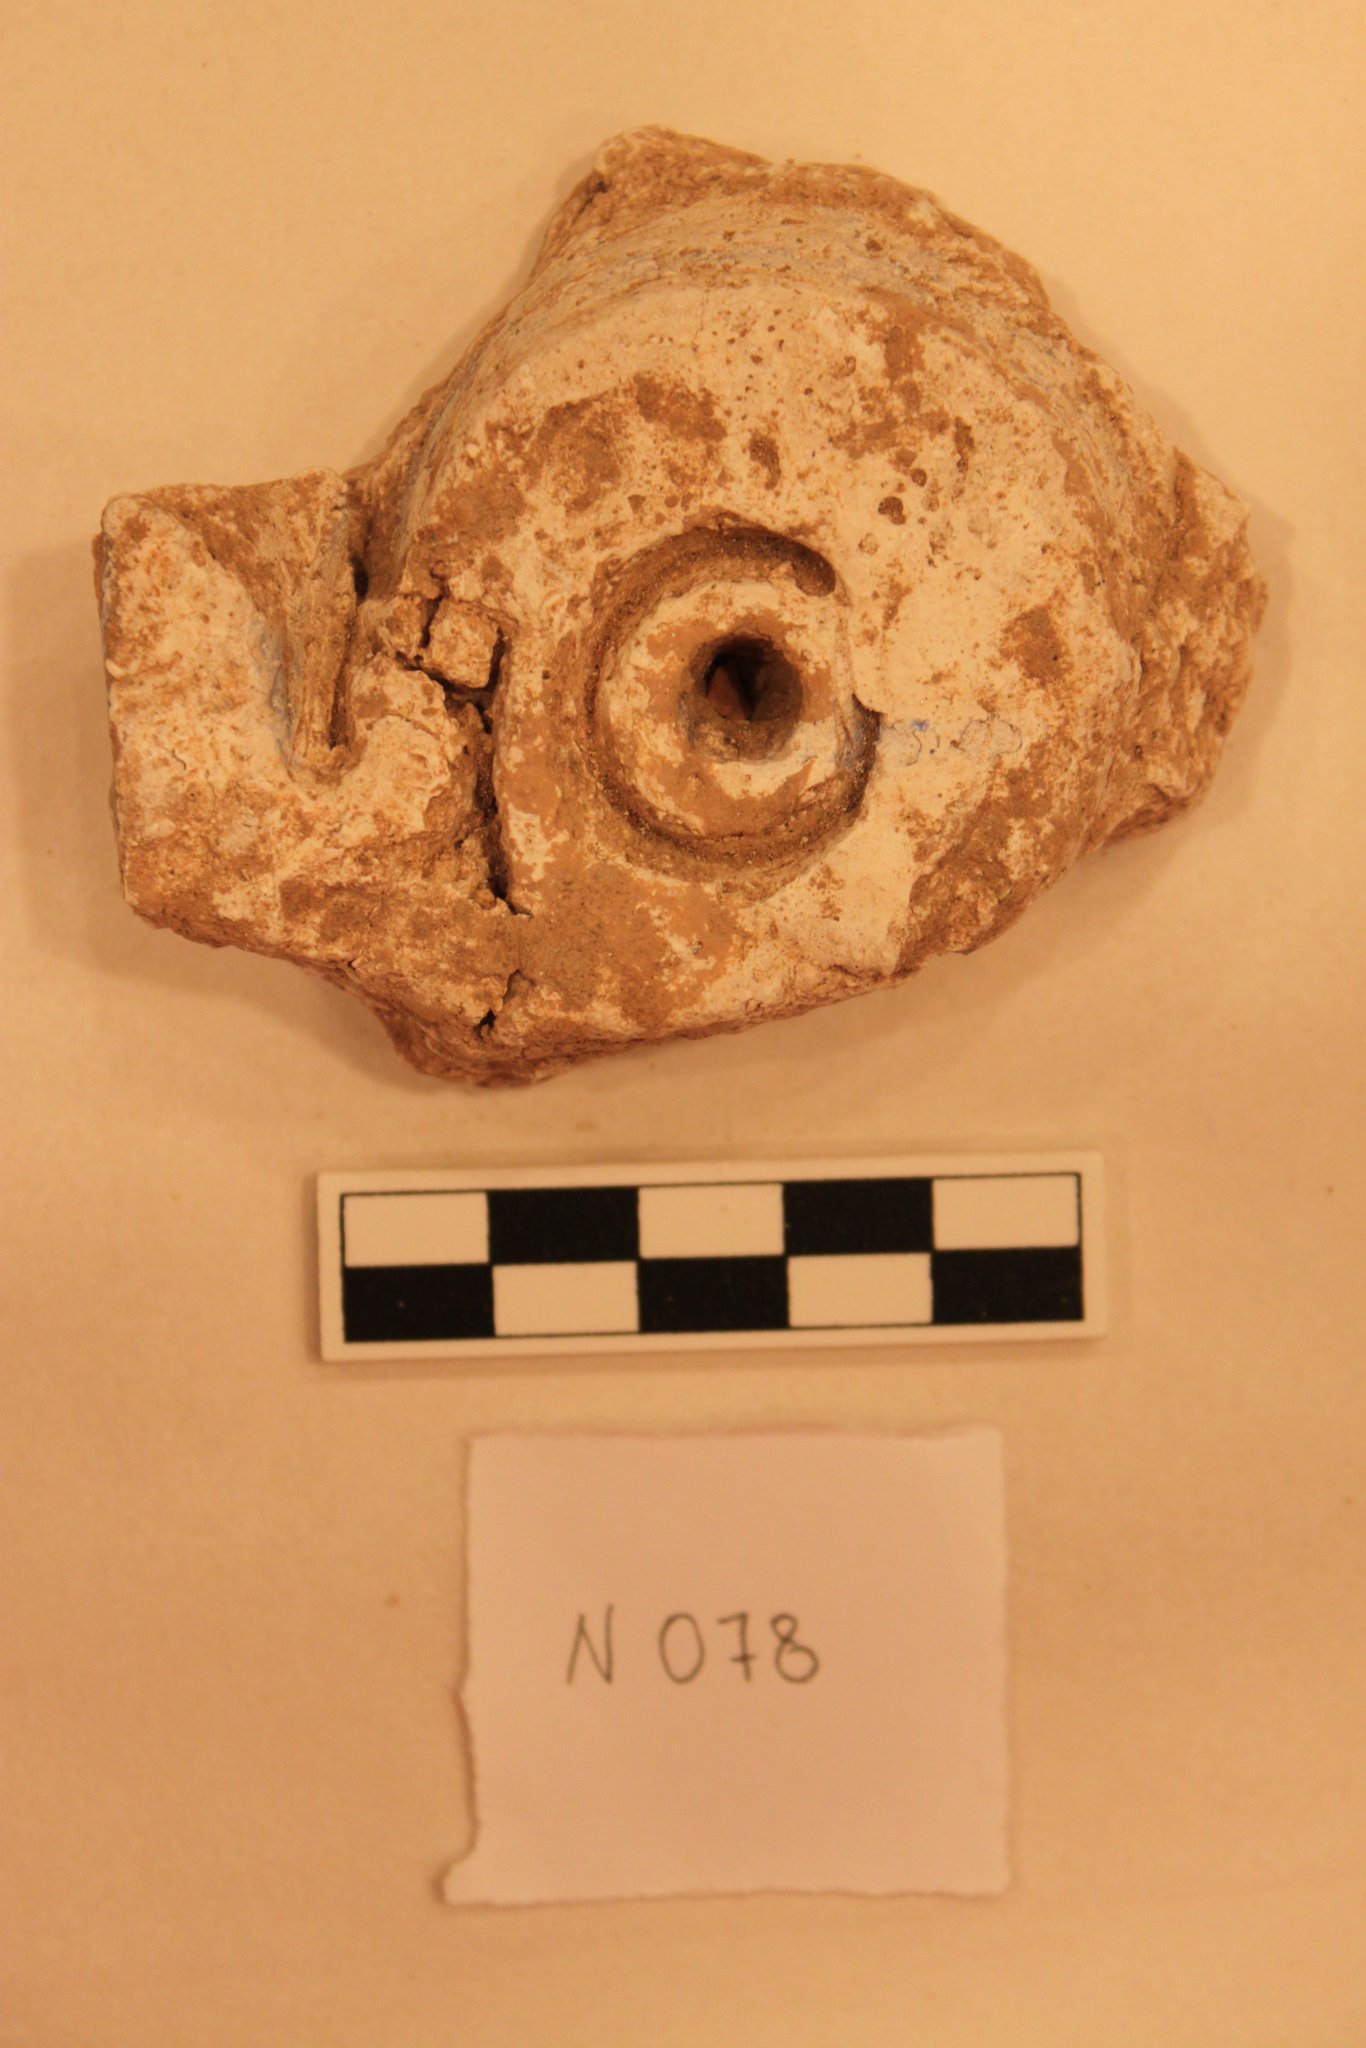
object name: fragment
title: Stucco Fragment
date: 701-1200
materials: plaster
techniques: carving, painting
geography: iran